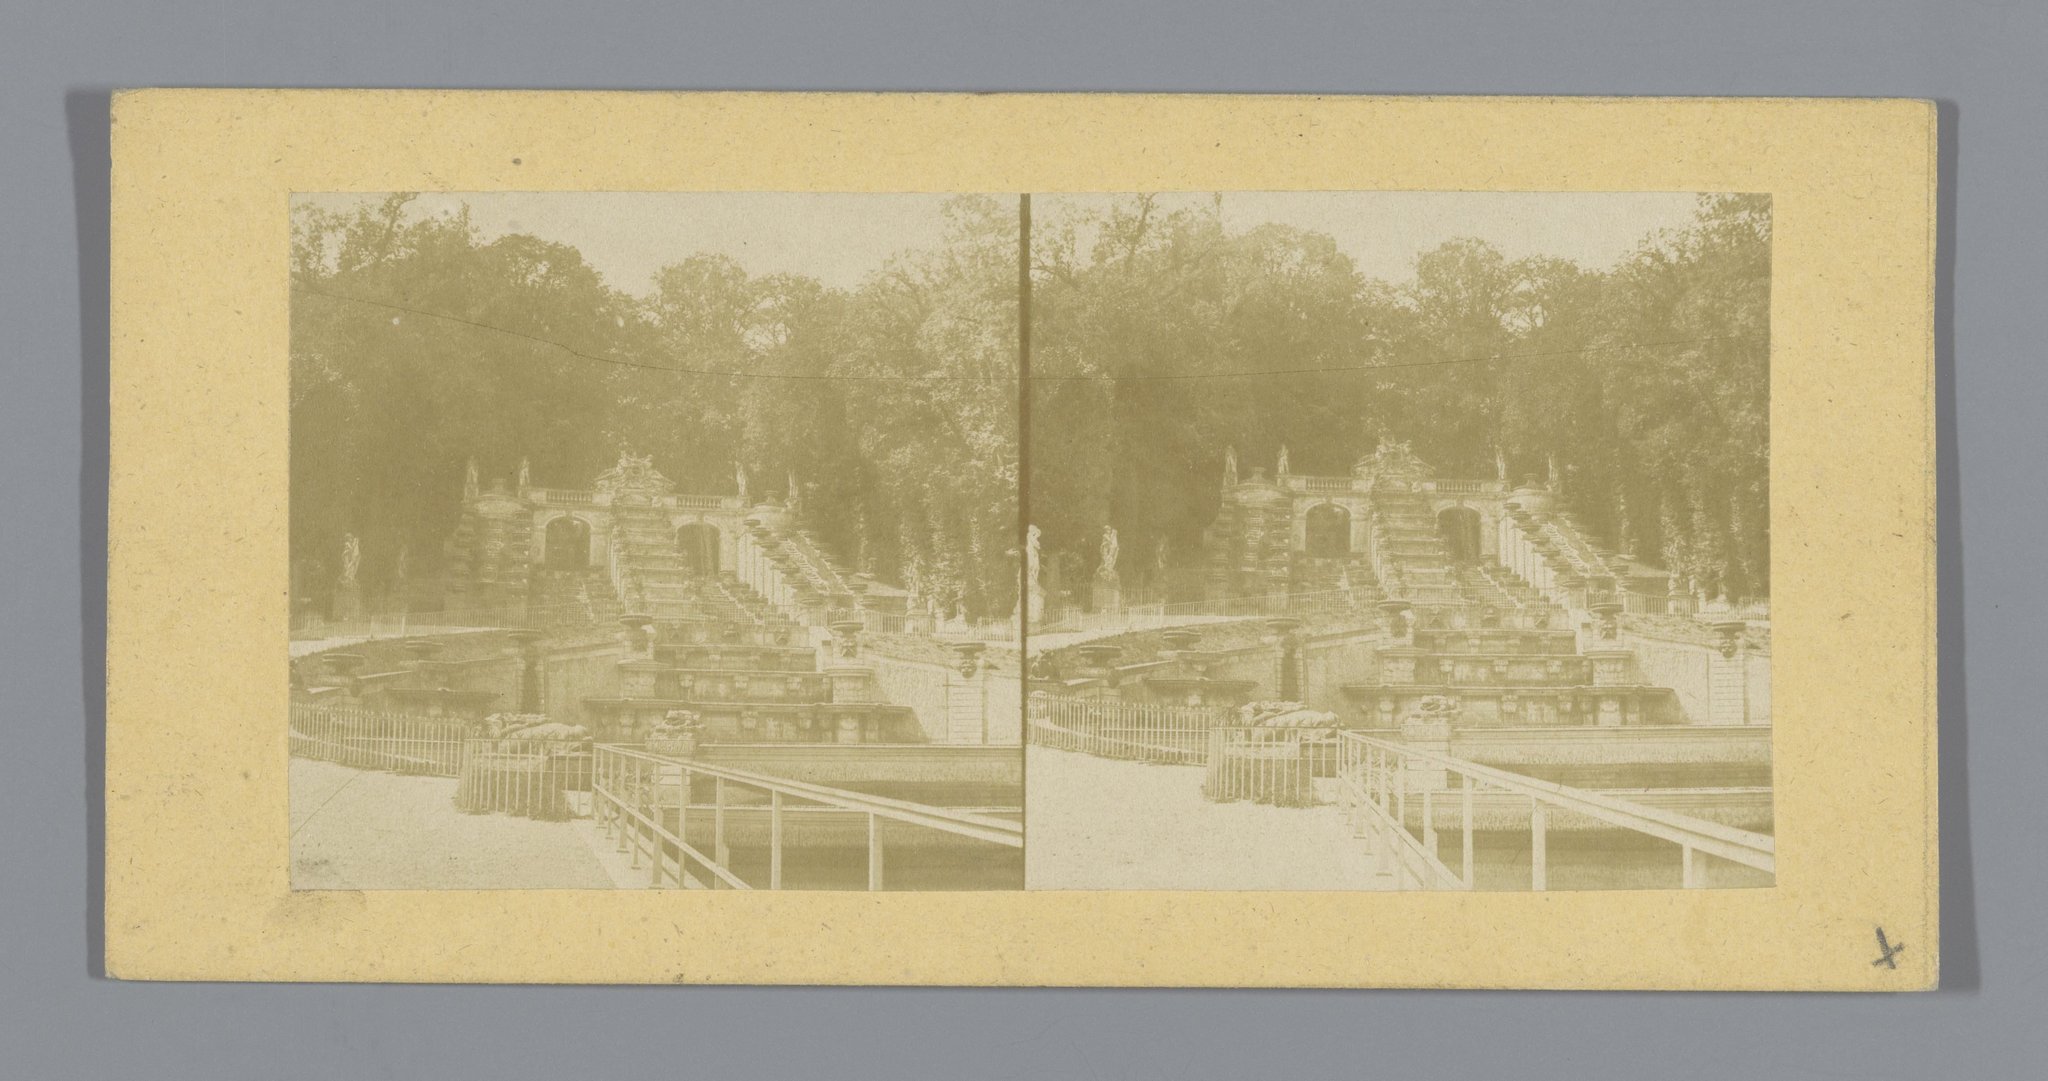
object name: stereograph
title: Watervallen in de tuin van het Kasteel van Saint-Cloud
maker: Anonymous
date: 1850-1870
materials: cardboard, photographic support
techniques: albumen print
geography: saint-cloud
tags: garden cascade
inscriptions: inscription: ‘St Cloud’, inscription: ‘168 Rue de Rivoli Gd. hôtel du Louvre Ledot Jne. Editeur Estampes, Photographies Plans et Guides pour Voyageurs’